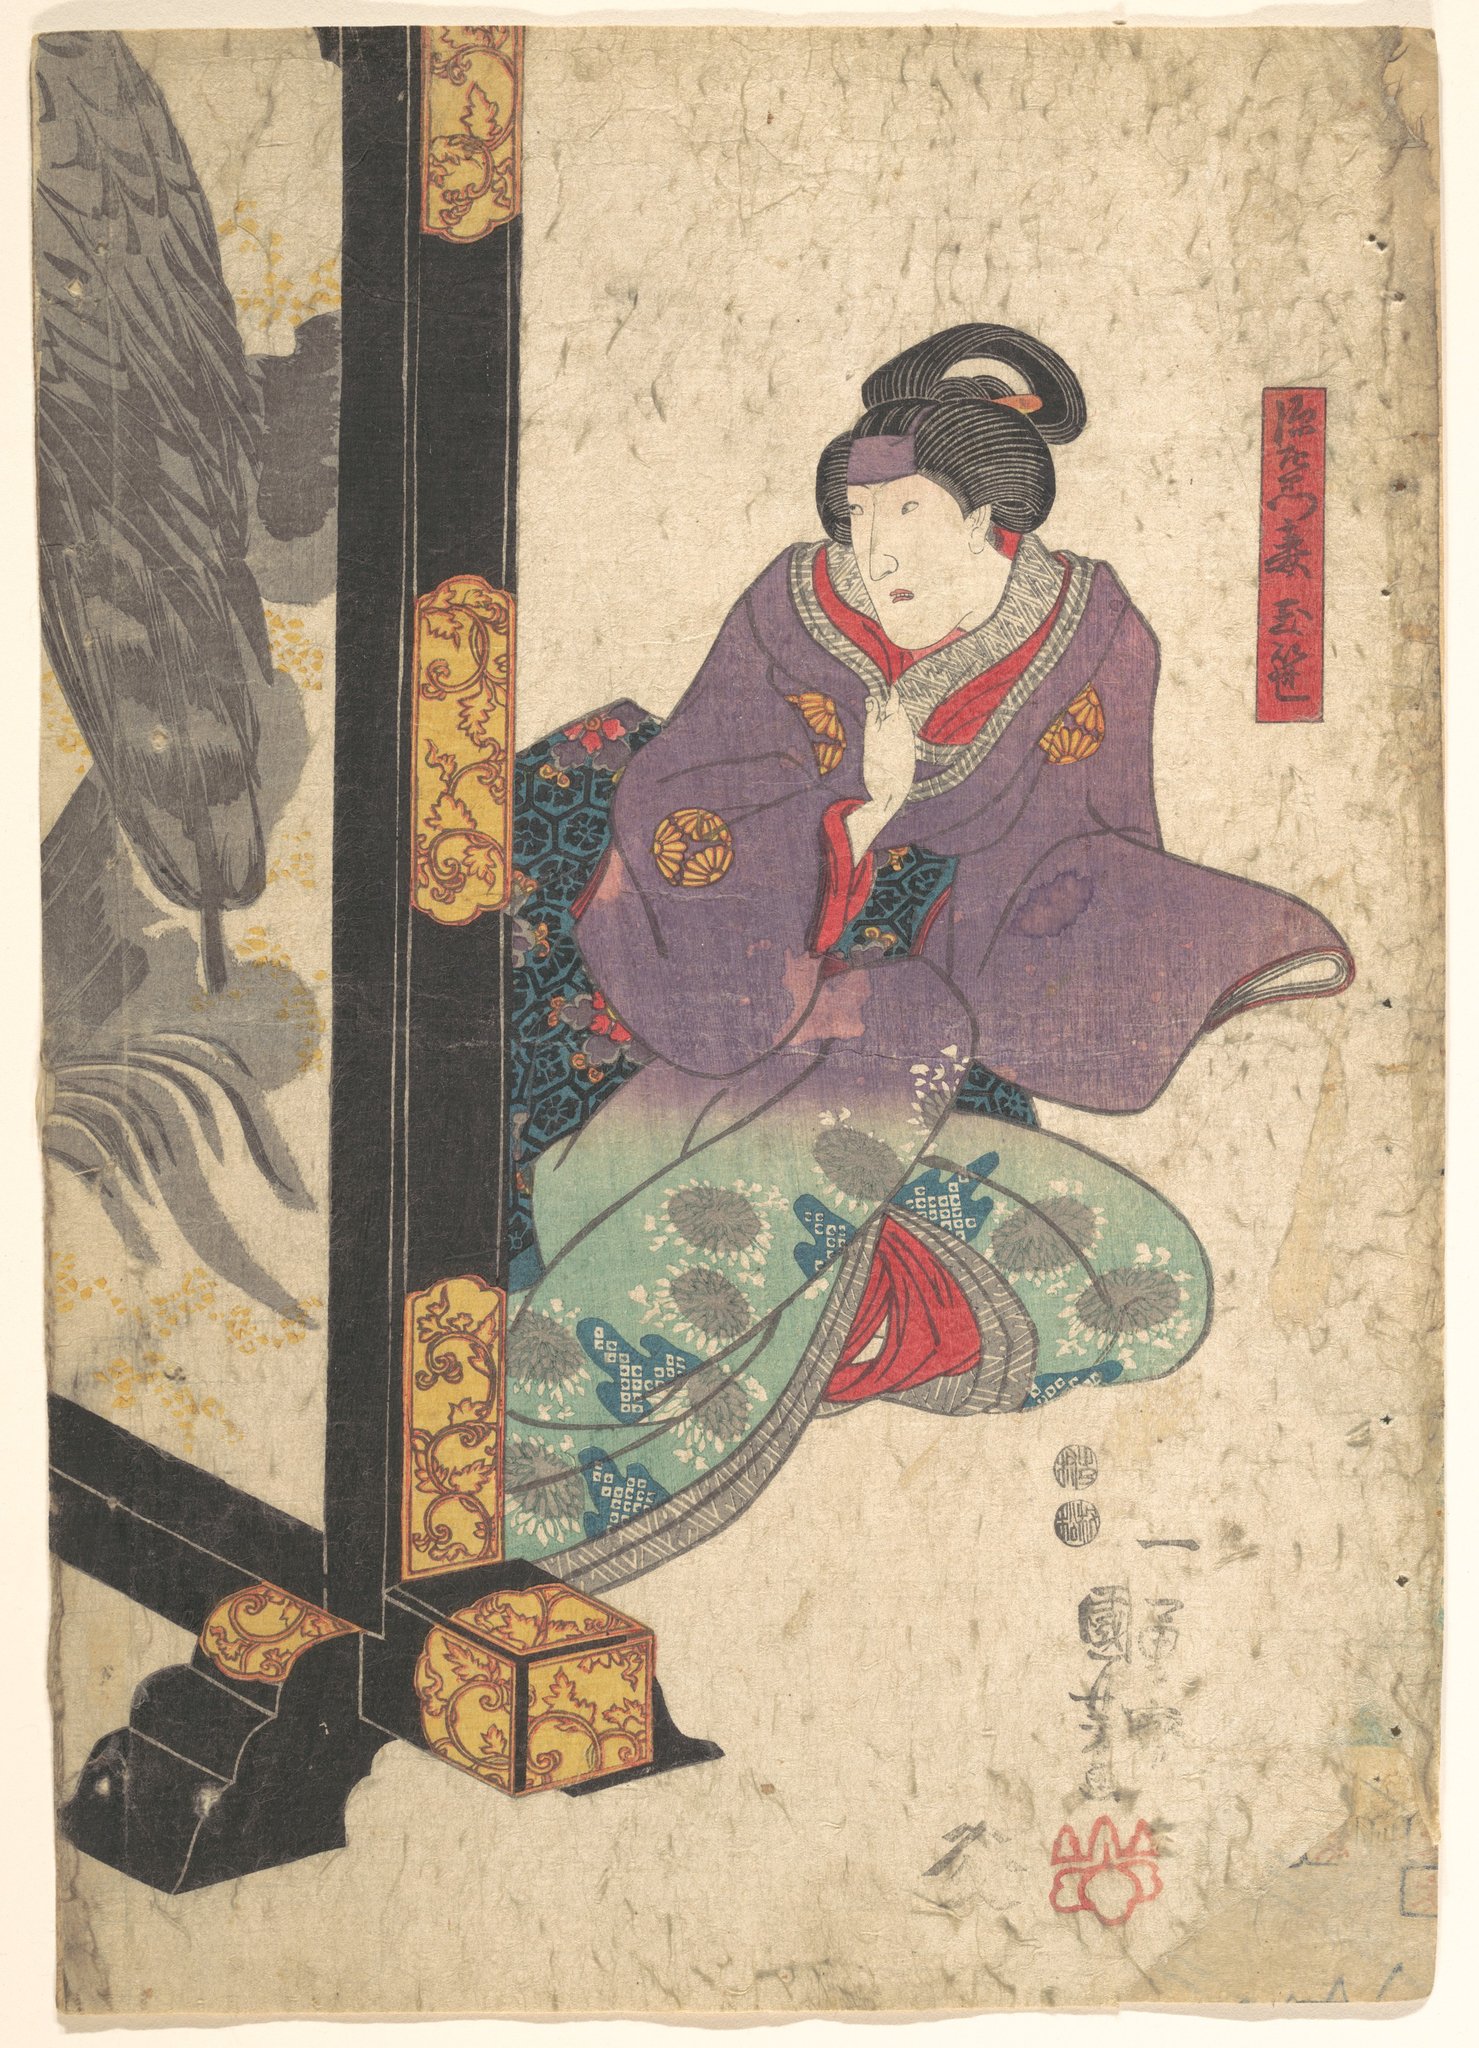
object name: print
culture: japanese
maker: utagawa kuniyoshi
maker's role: artist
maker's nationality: japanese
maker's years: 1797-1861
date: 1801-1900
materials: ink, paper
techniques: woodblock print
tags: human figures